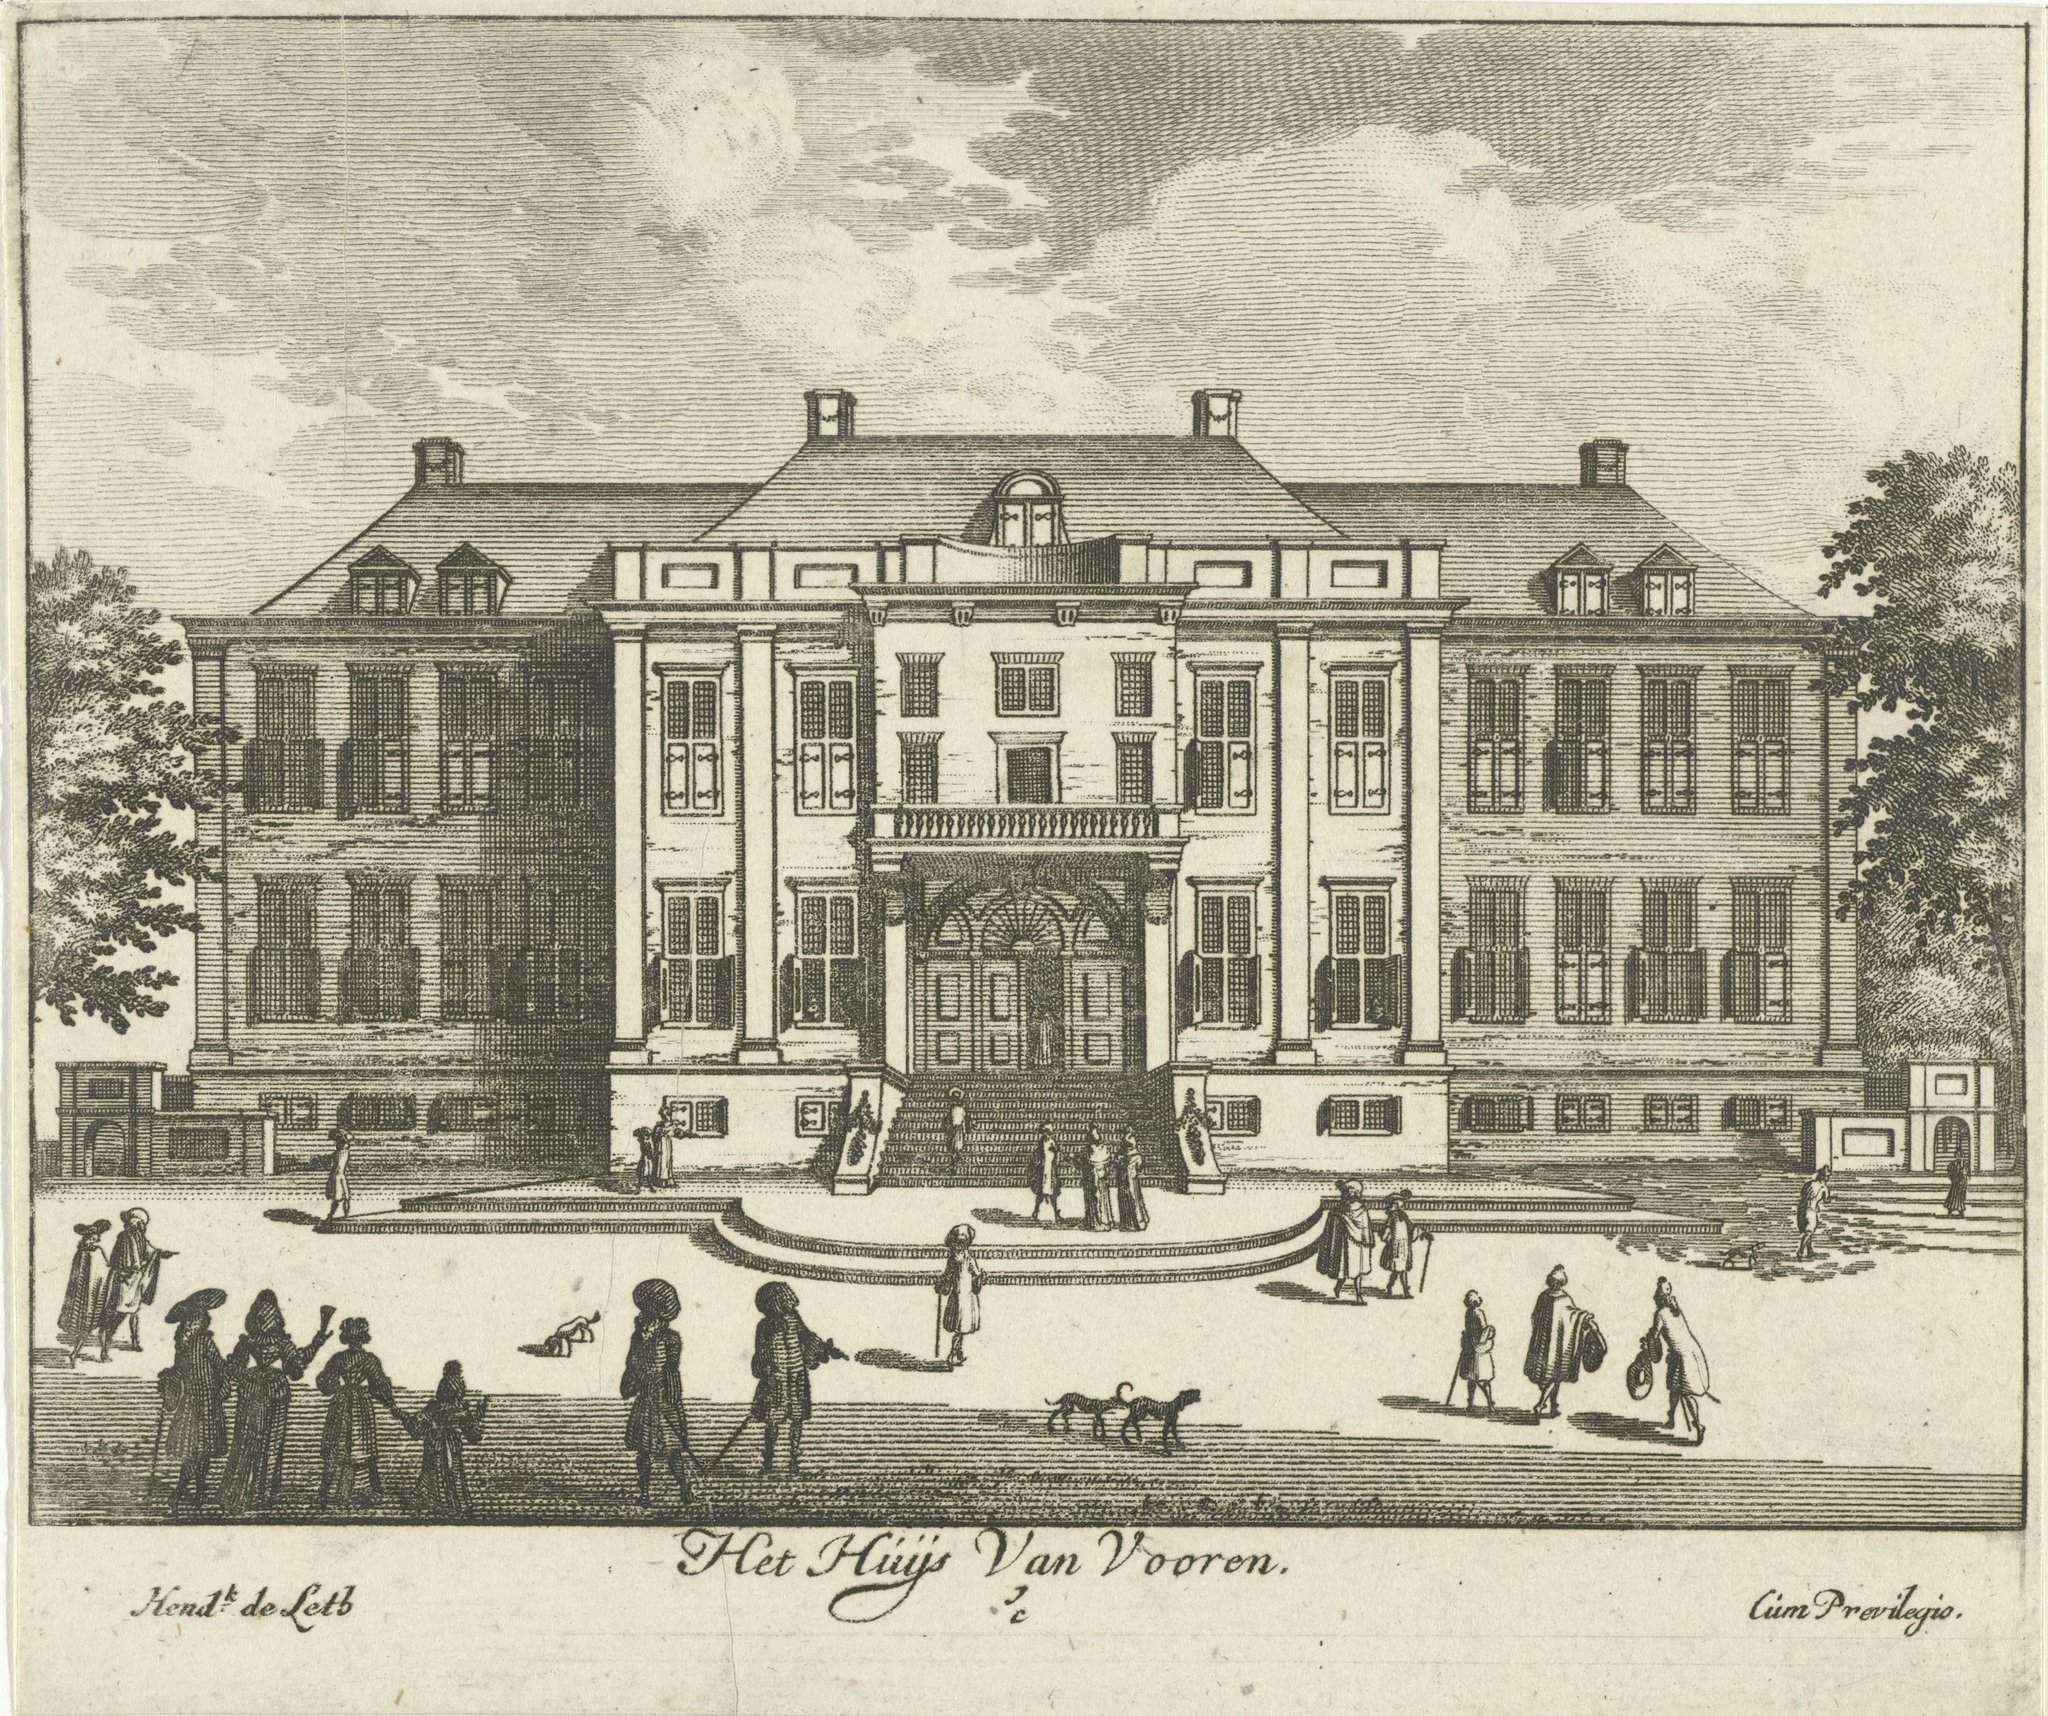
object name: print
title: Generale Afbeeldinge Vant Lust-Huijs en Hof van sijn Koninklijcke Majestijt van Groot Brittanie t Soest-Dijk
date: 1725-1747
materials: paper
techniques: etching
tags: palace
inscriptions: collector's mark: Lugt 2228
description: Gezicht op de voorgevel van Paleis Soestdijk met wandelende figuren op de voorgrond. De prent maakt deel uit van een serie met zestien gezichten op Paleis Soestdijk en het bijbehorende landgoed.